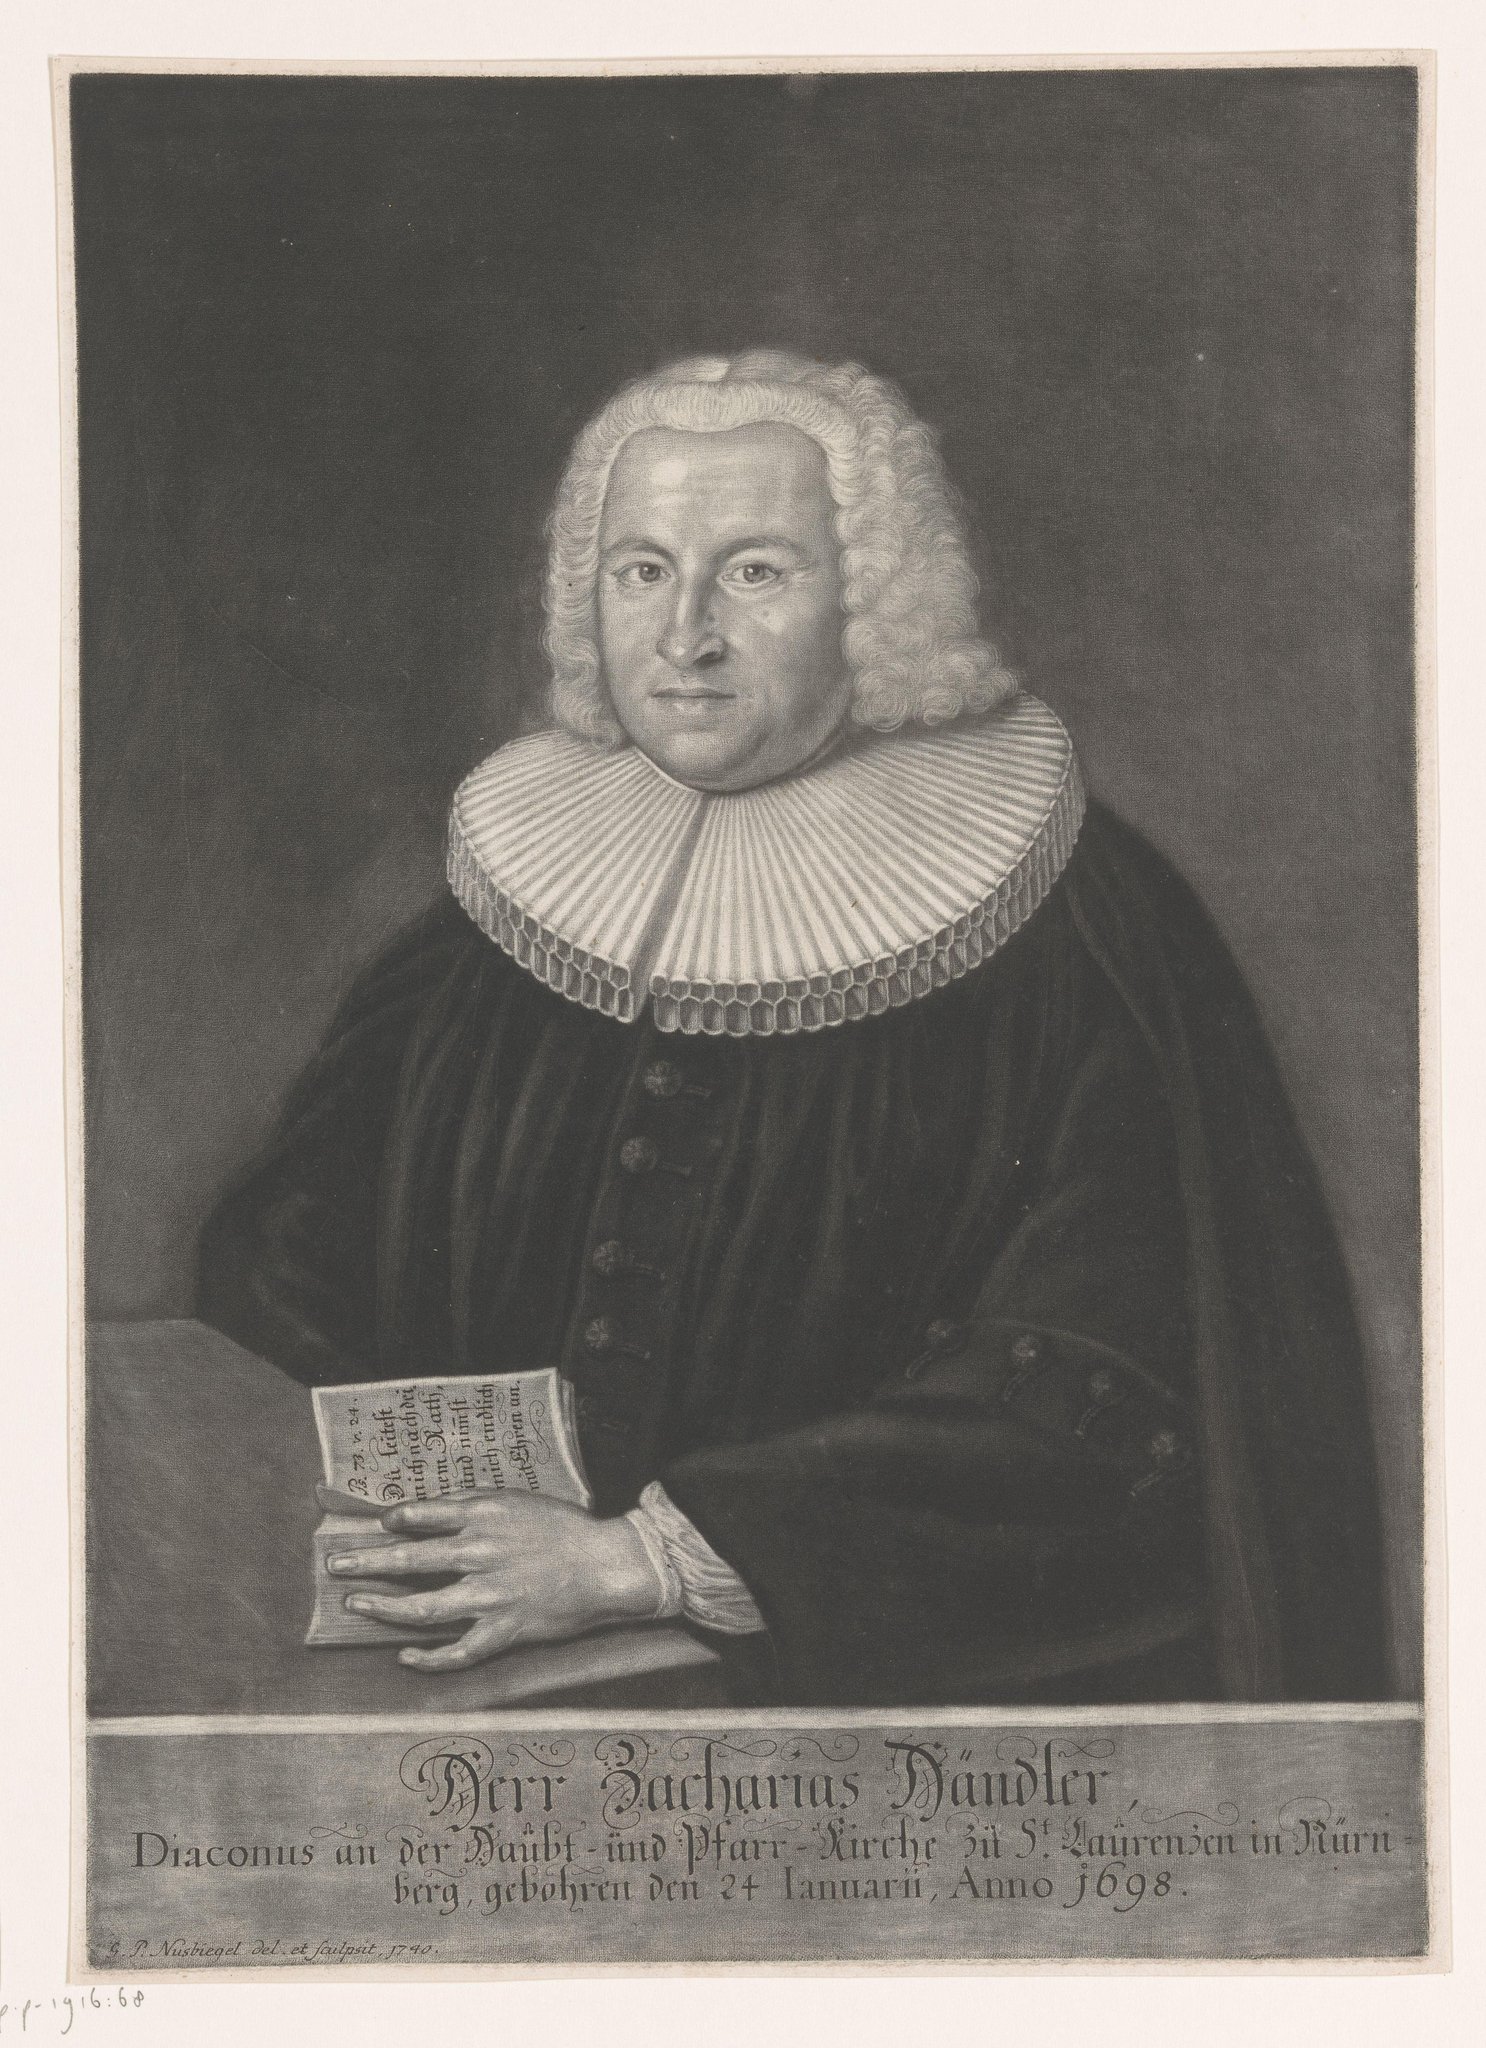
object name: print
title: Portret van Zacharias Händler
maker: georg paul nusbiegel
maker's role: print maker, publisher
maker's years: 1713-1776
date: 1740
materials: paper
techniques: mezzotint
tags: historical persons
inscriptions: collector's mark: Lugt 2228